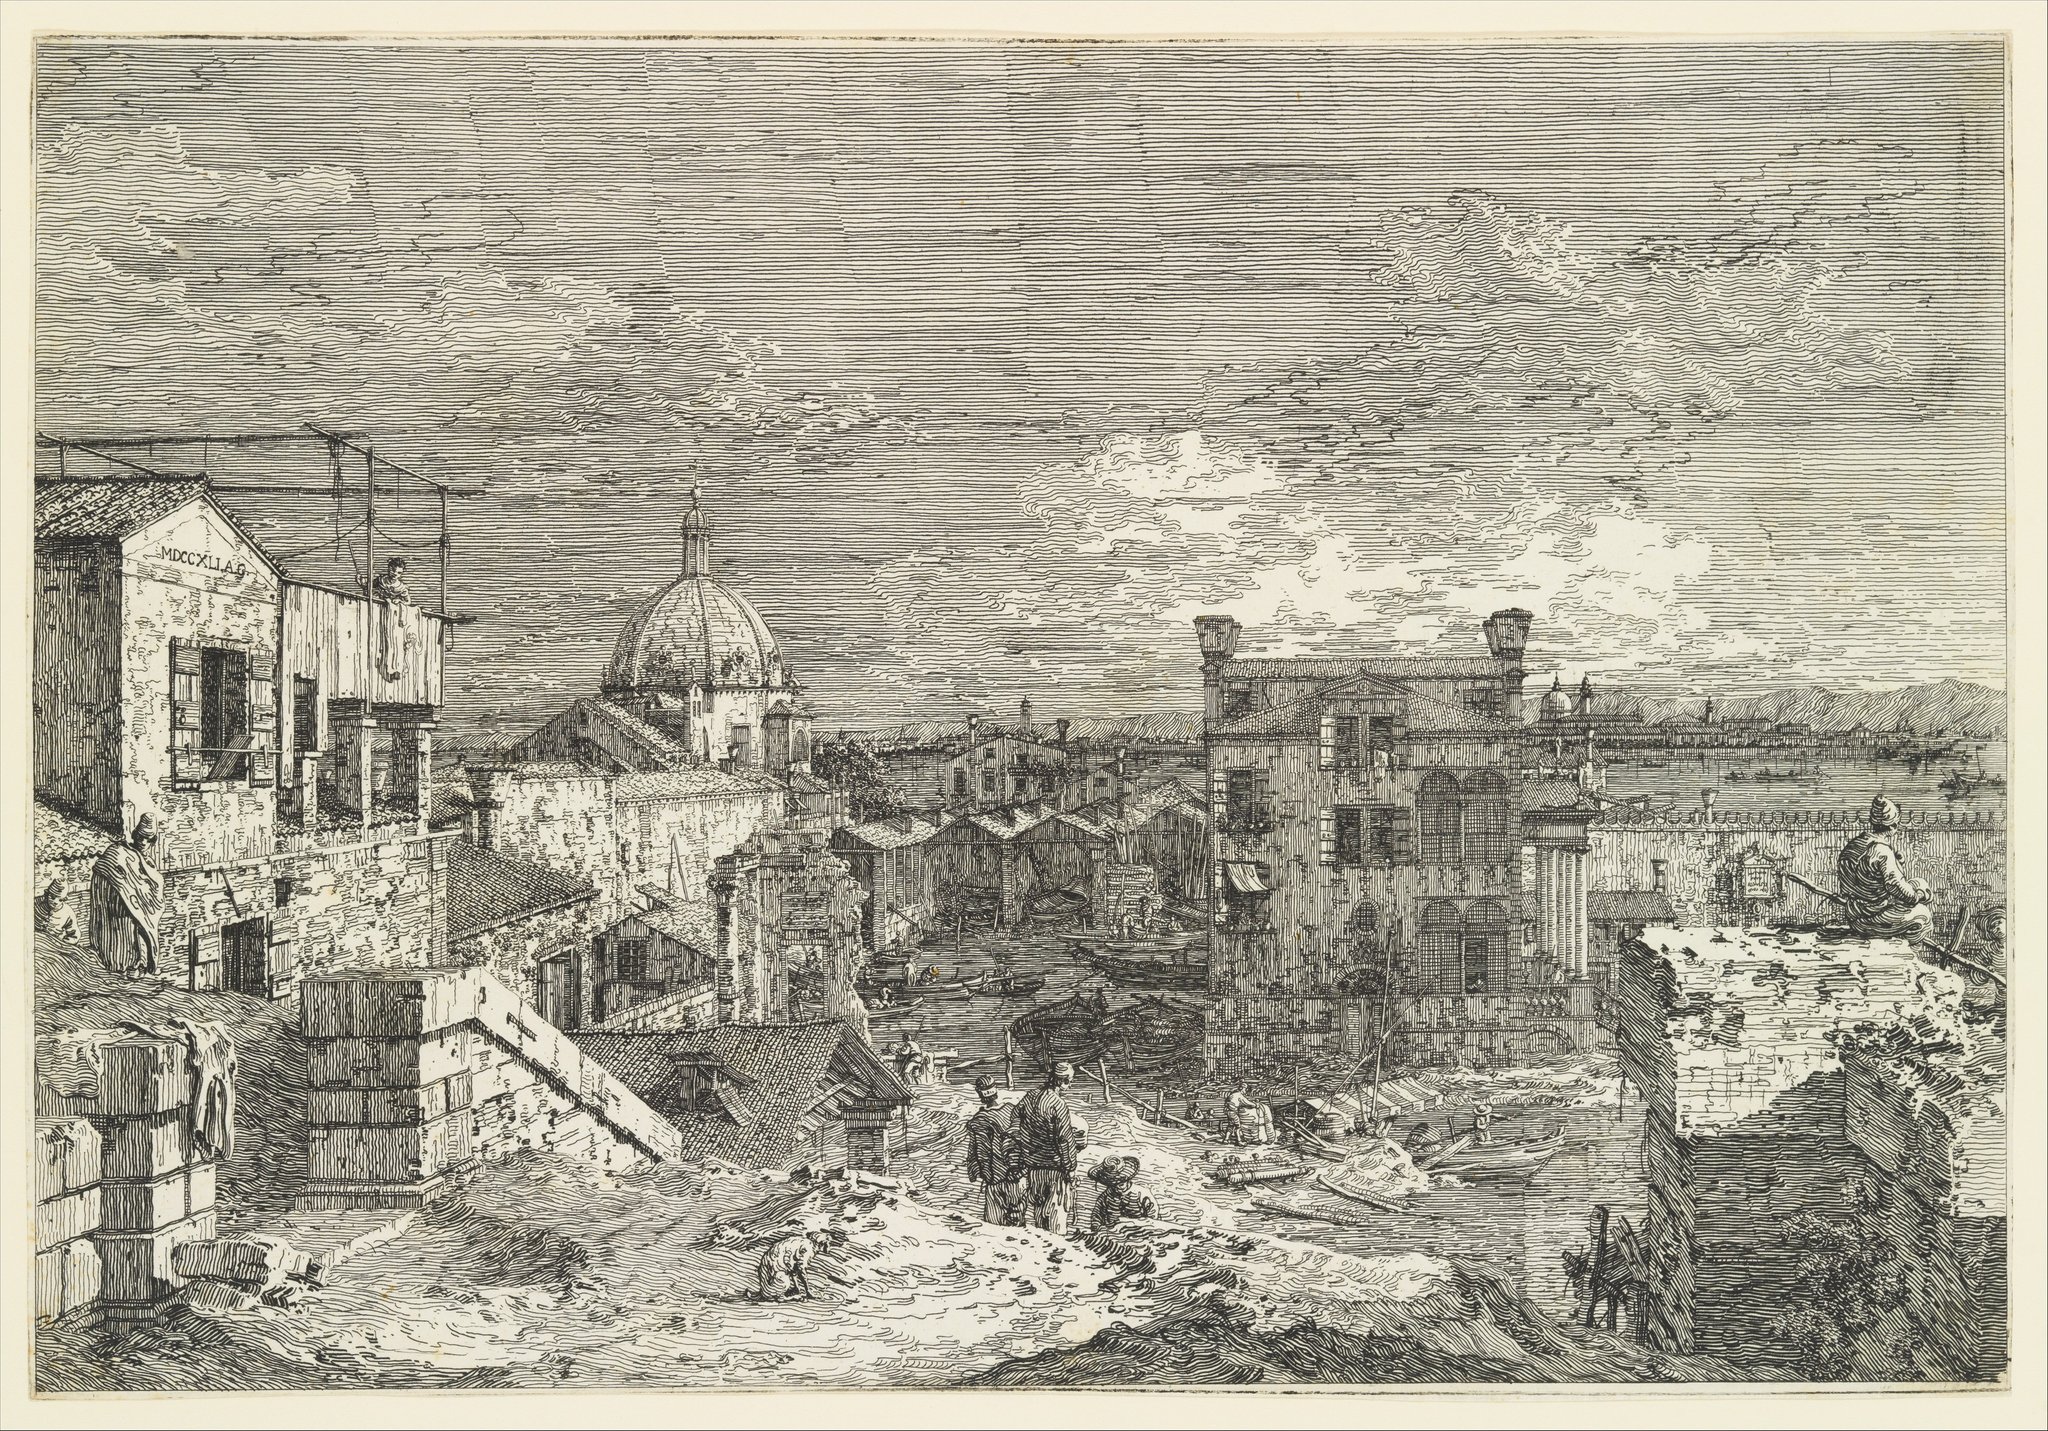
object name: print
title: Imaginary View of Venice, houses at left with figures on terraces, a domed church at center in the background, boats and boat-sheds below, and a seated man observing from a wall at right in the foreground, from "Views" (Vedute altre prese da i luoghi altre ideate da Antonio Canal)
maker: canaletto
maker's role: artist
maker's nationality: italian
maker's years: 1697-1768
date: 1741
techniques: etching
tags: cities,churches,boats,venice